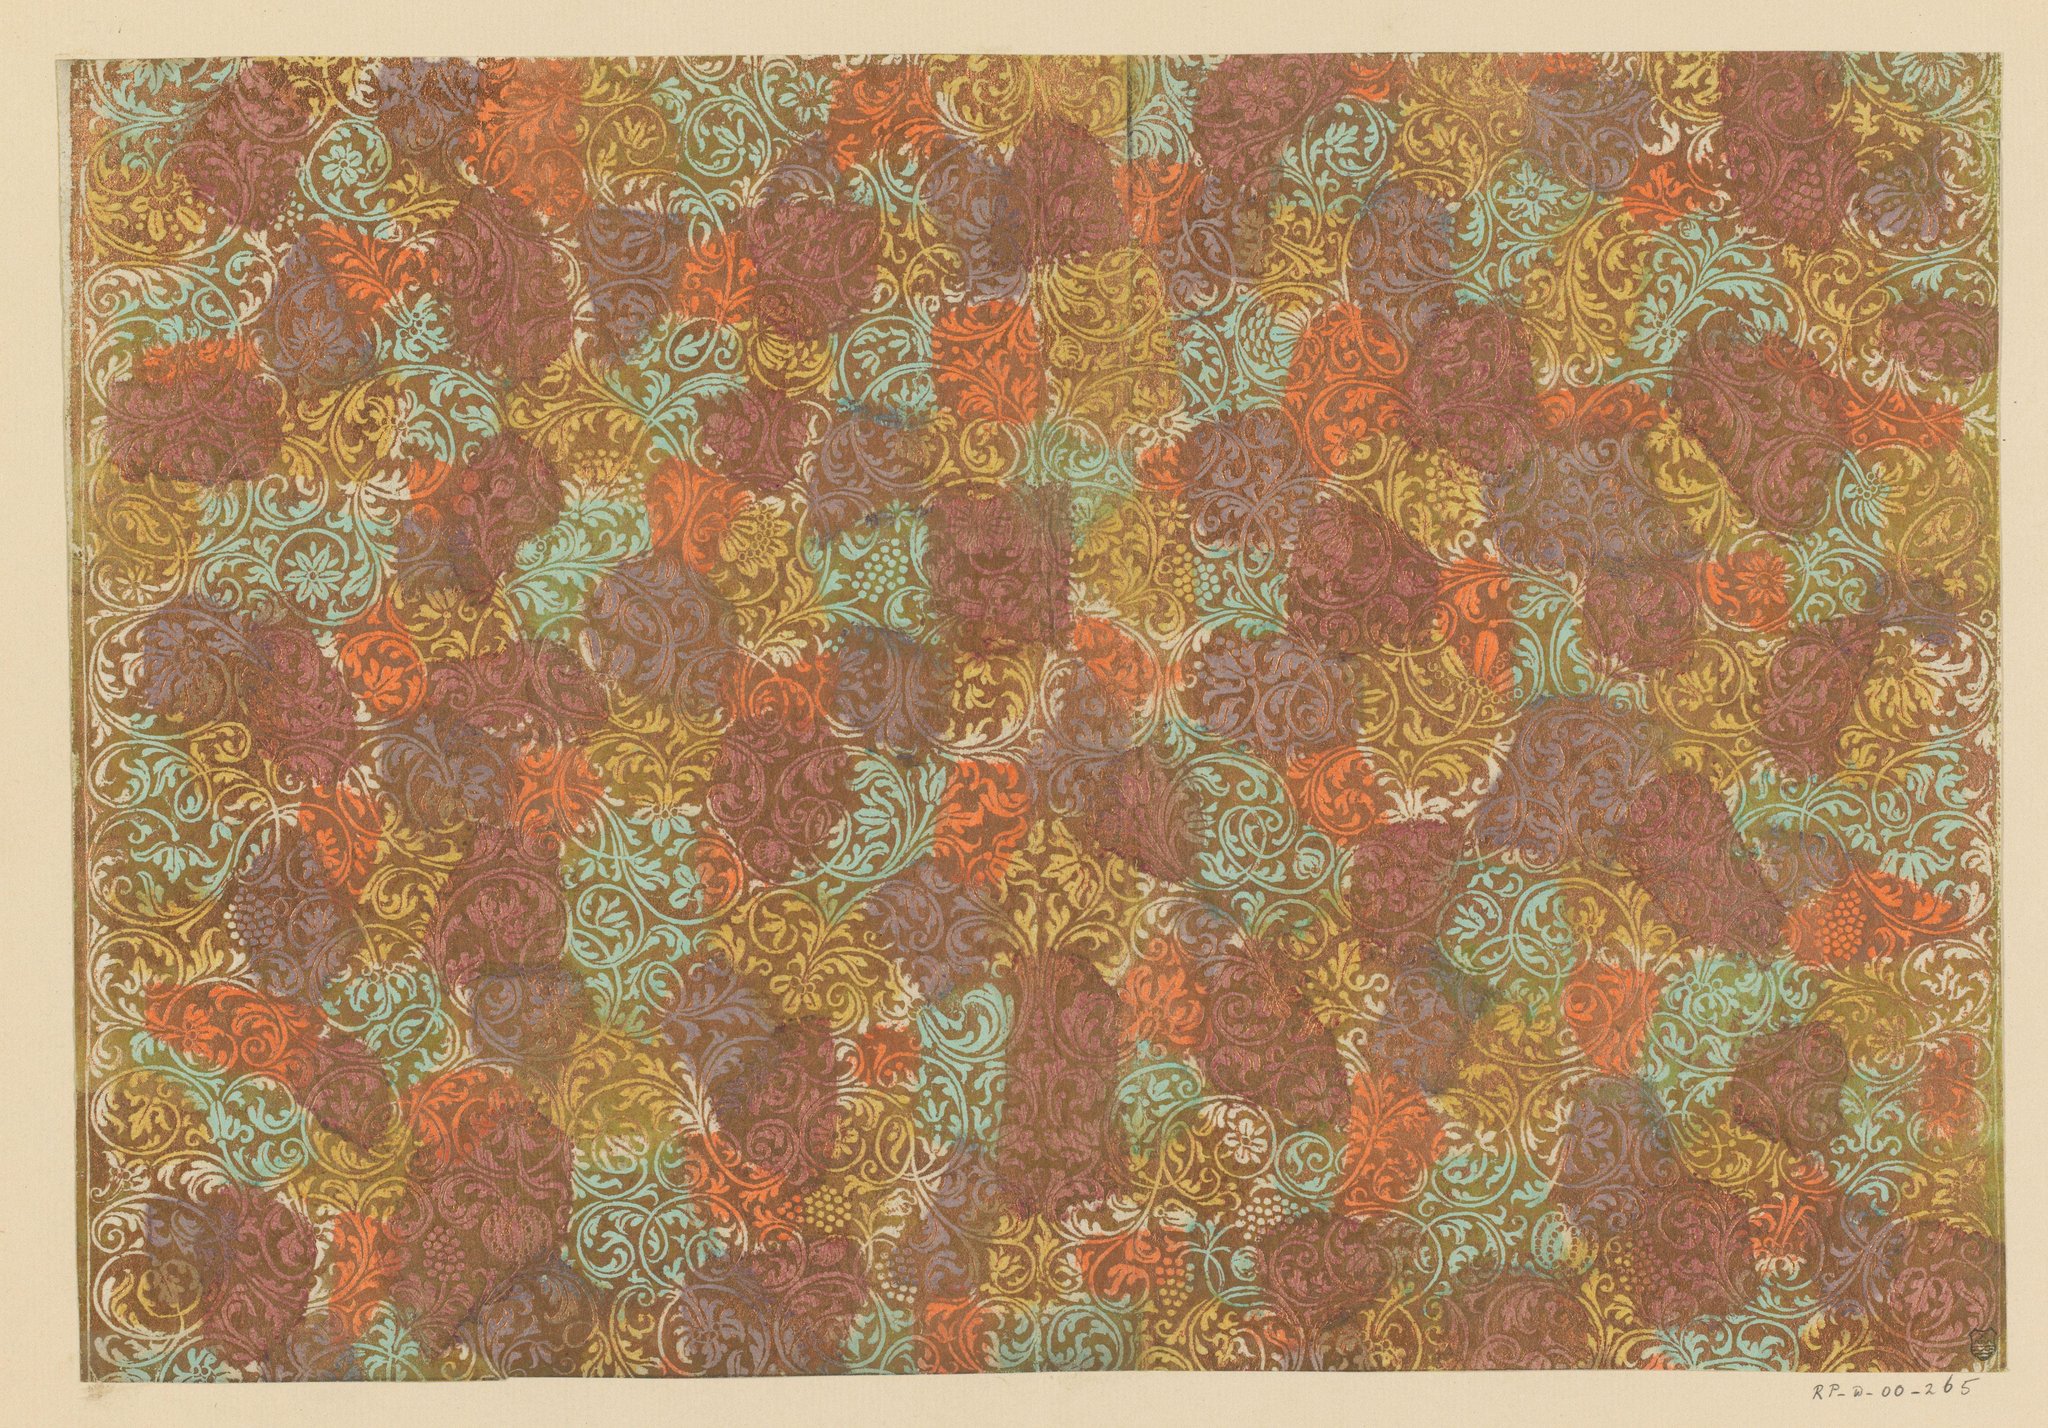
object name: brocade paper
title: Blad met ranken met bloemen en vruchten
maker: johann wilhelm meyer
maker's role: papiermaker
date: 1740-1780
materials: gold leaf, paint, paper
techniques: relief print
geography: augsburg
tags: ornament derived from plant forms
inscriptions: collector's mark: Lugt 2760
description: Blad met ranken met bloemen en vruchten.